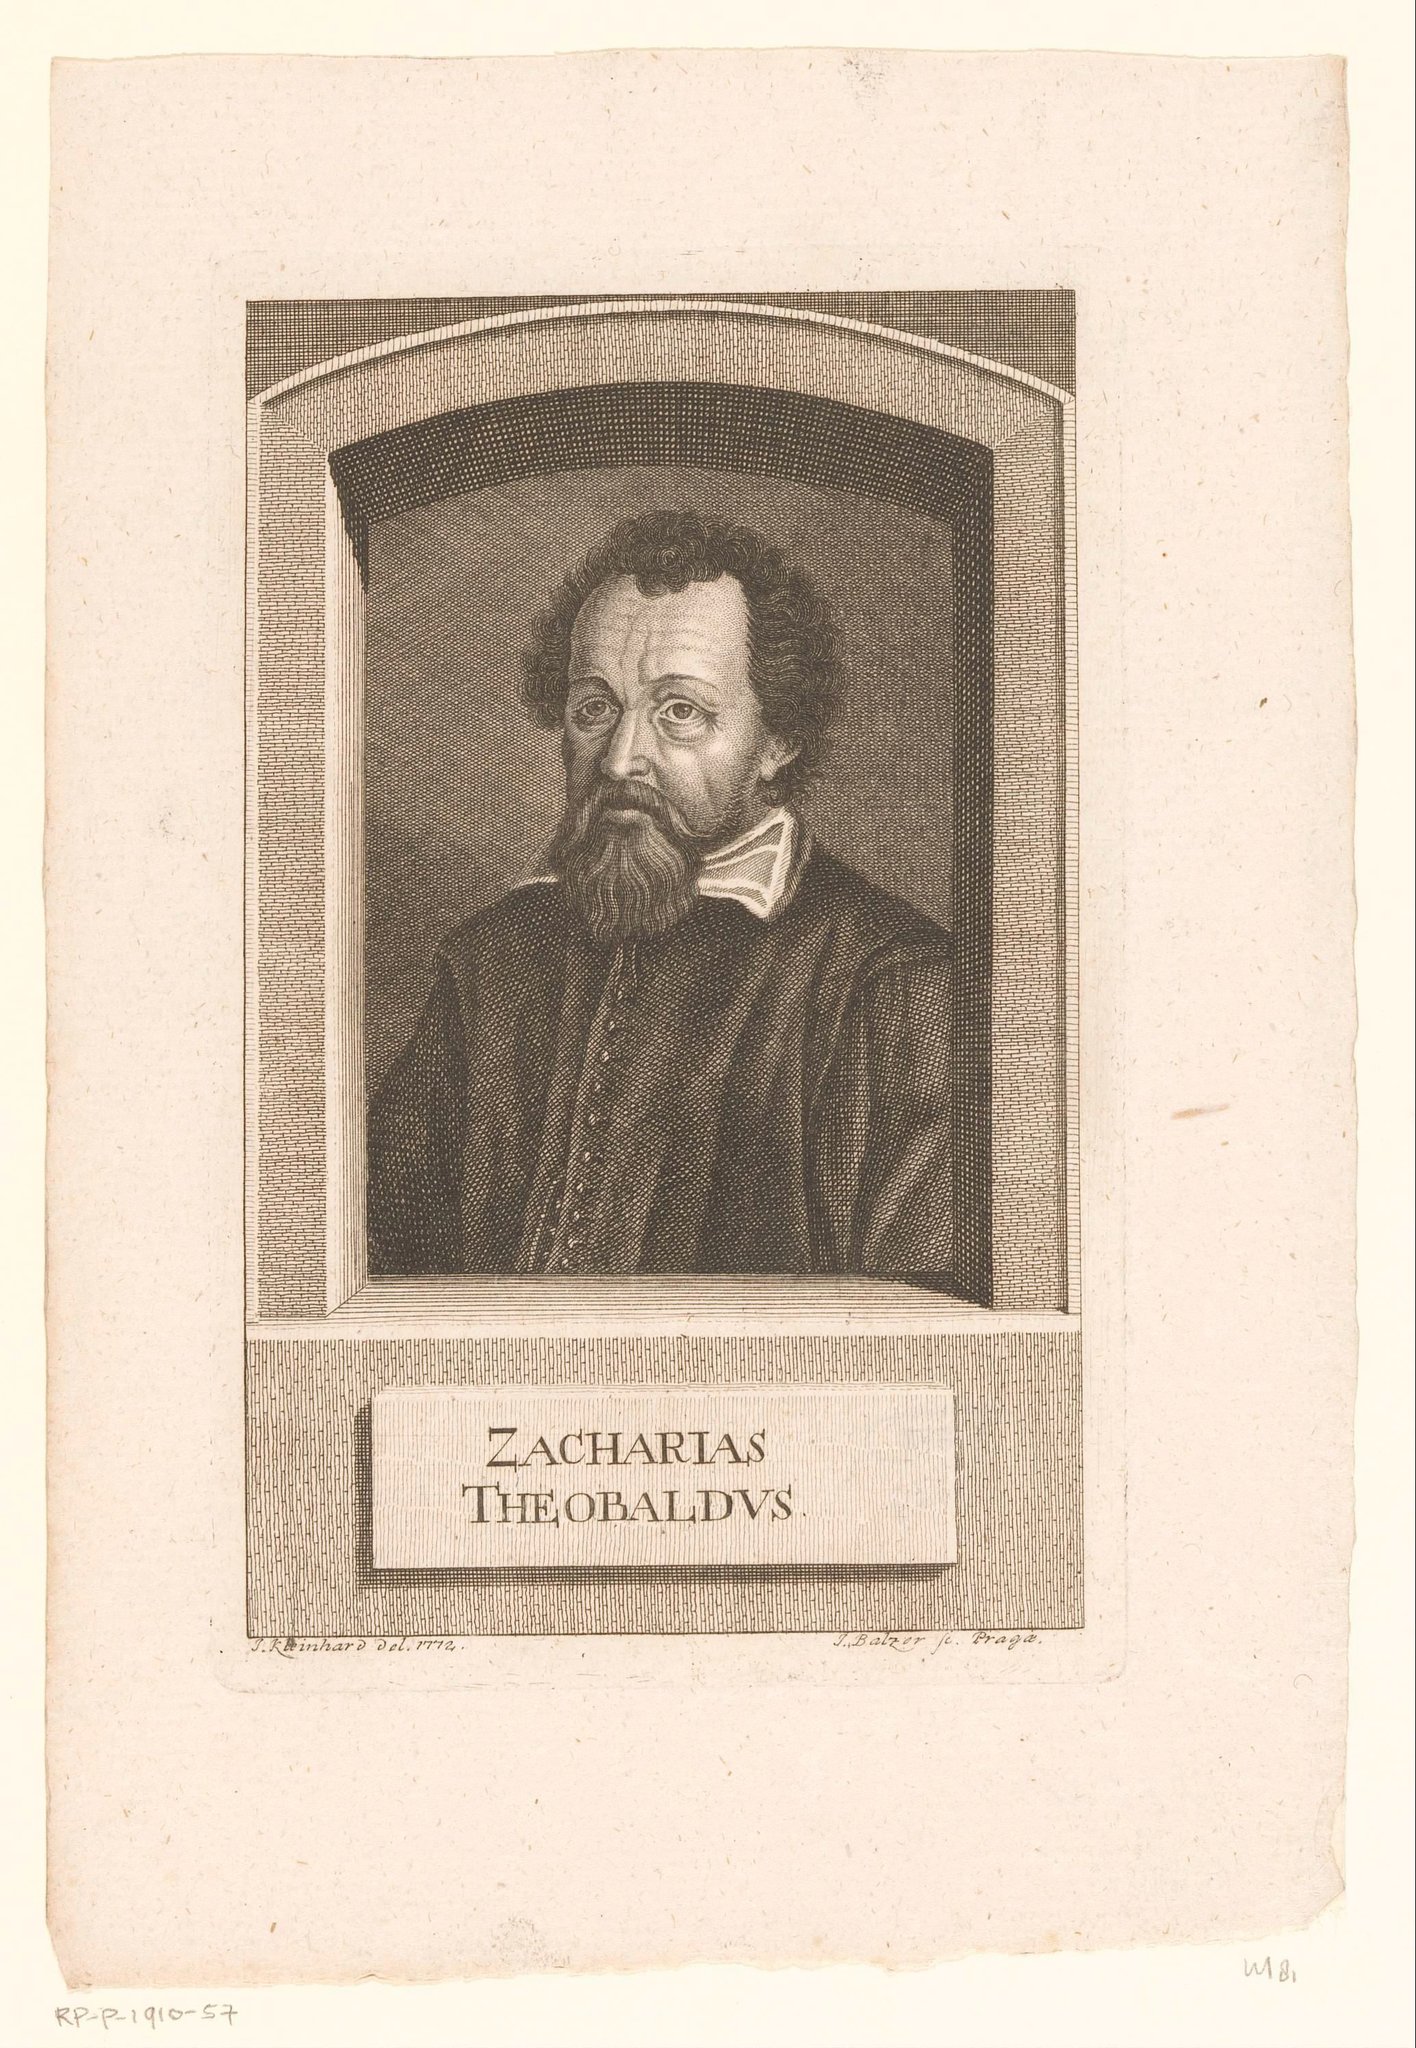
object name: print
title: Portret van Zacharias Theobald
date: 1772-1799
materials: paper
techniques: engraving, etching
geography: prague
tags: historical persons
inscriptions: collector's mark: Lugt 2228